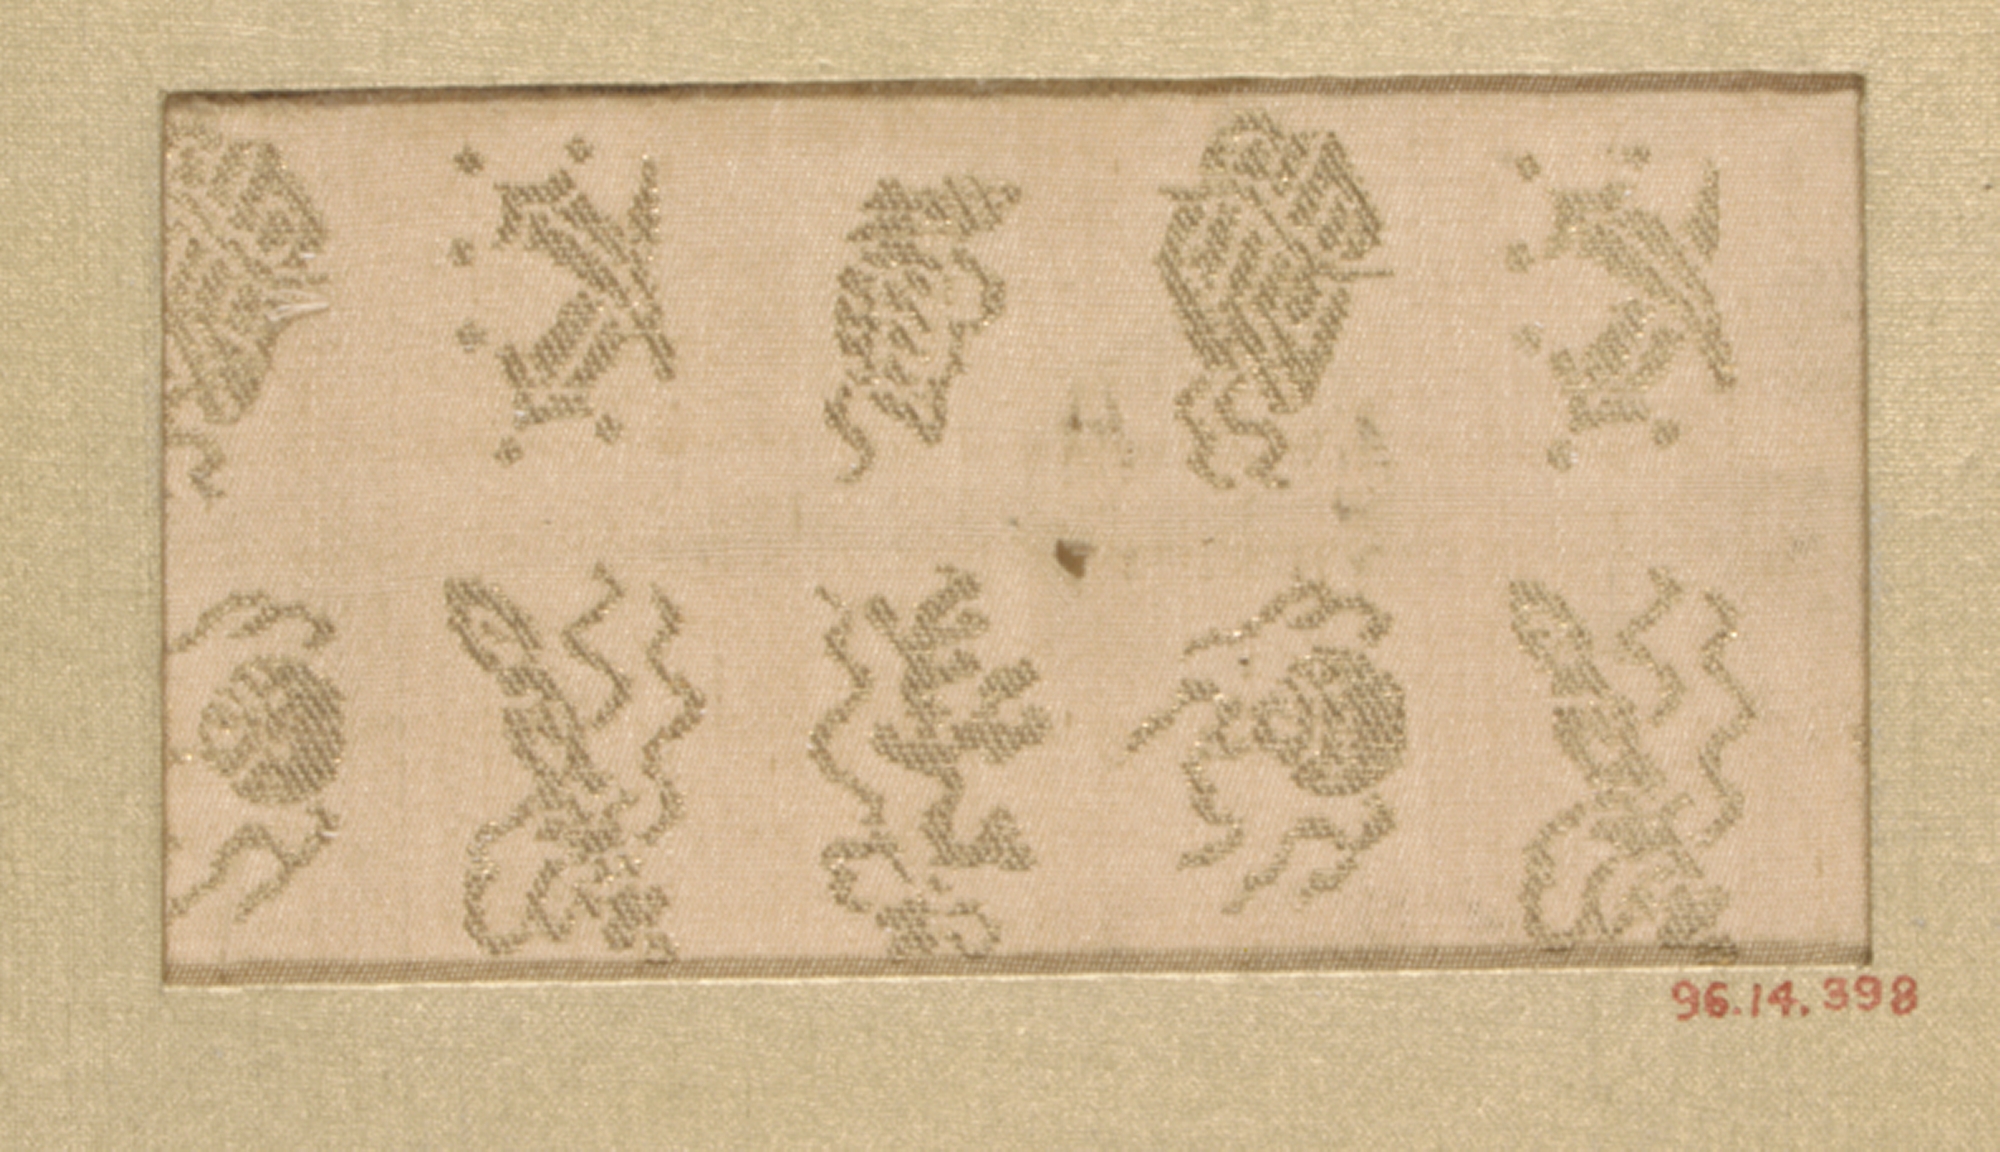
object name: piece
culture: japanese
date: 1701-1900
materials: silk